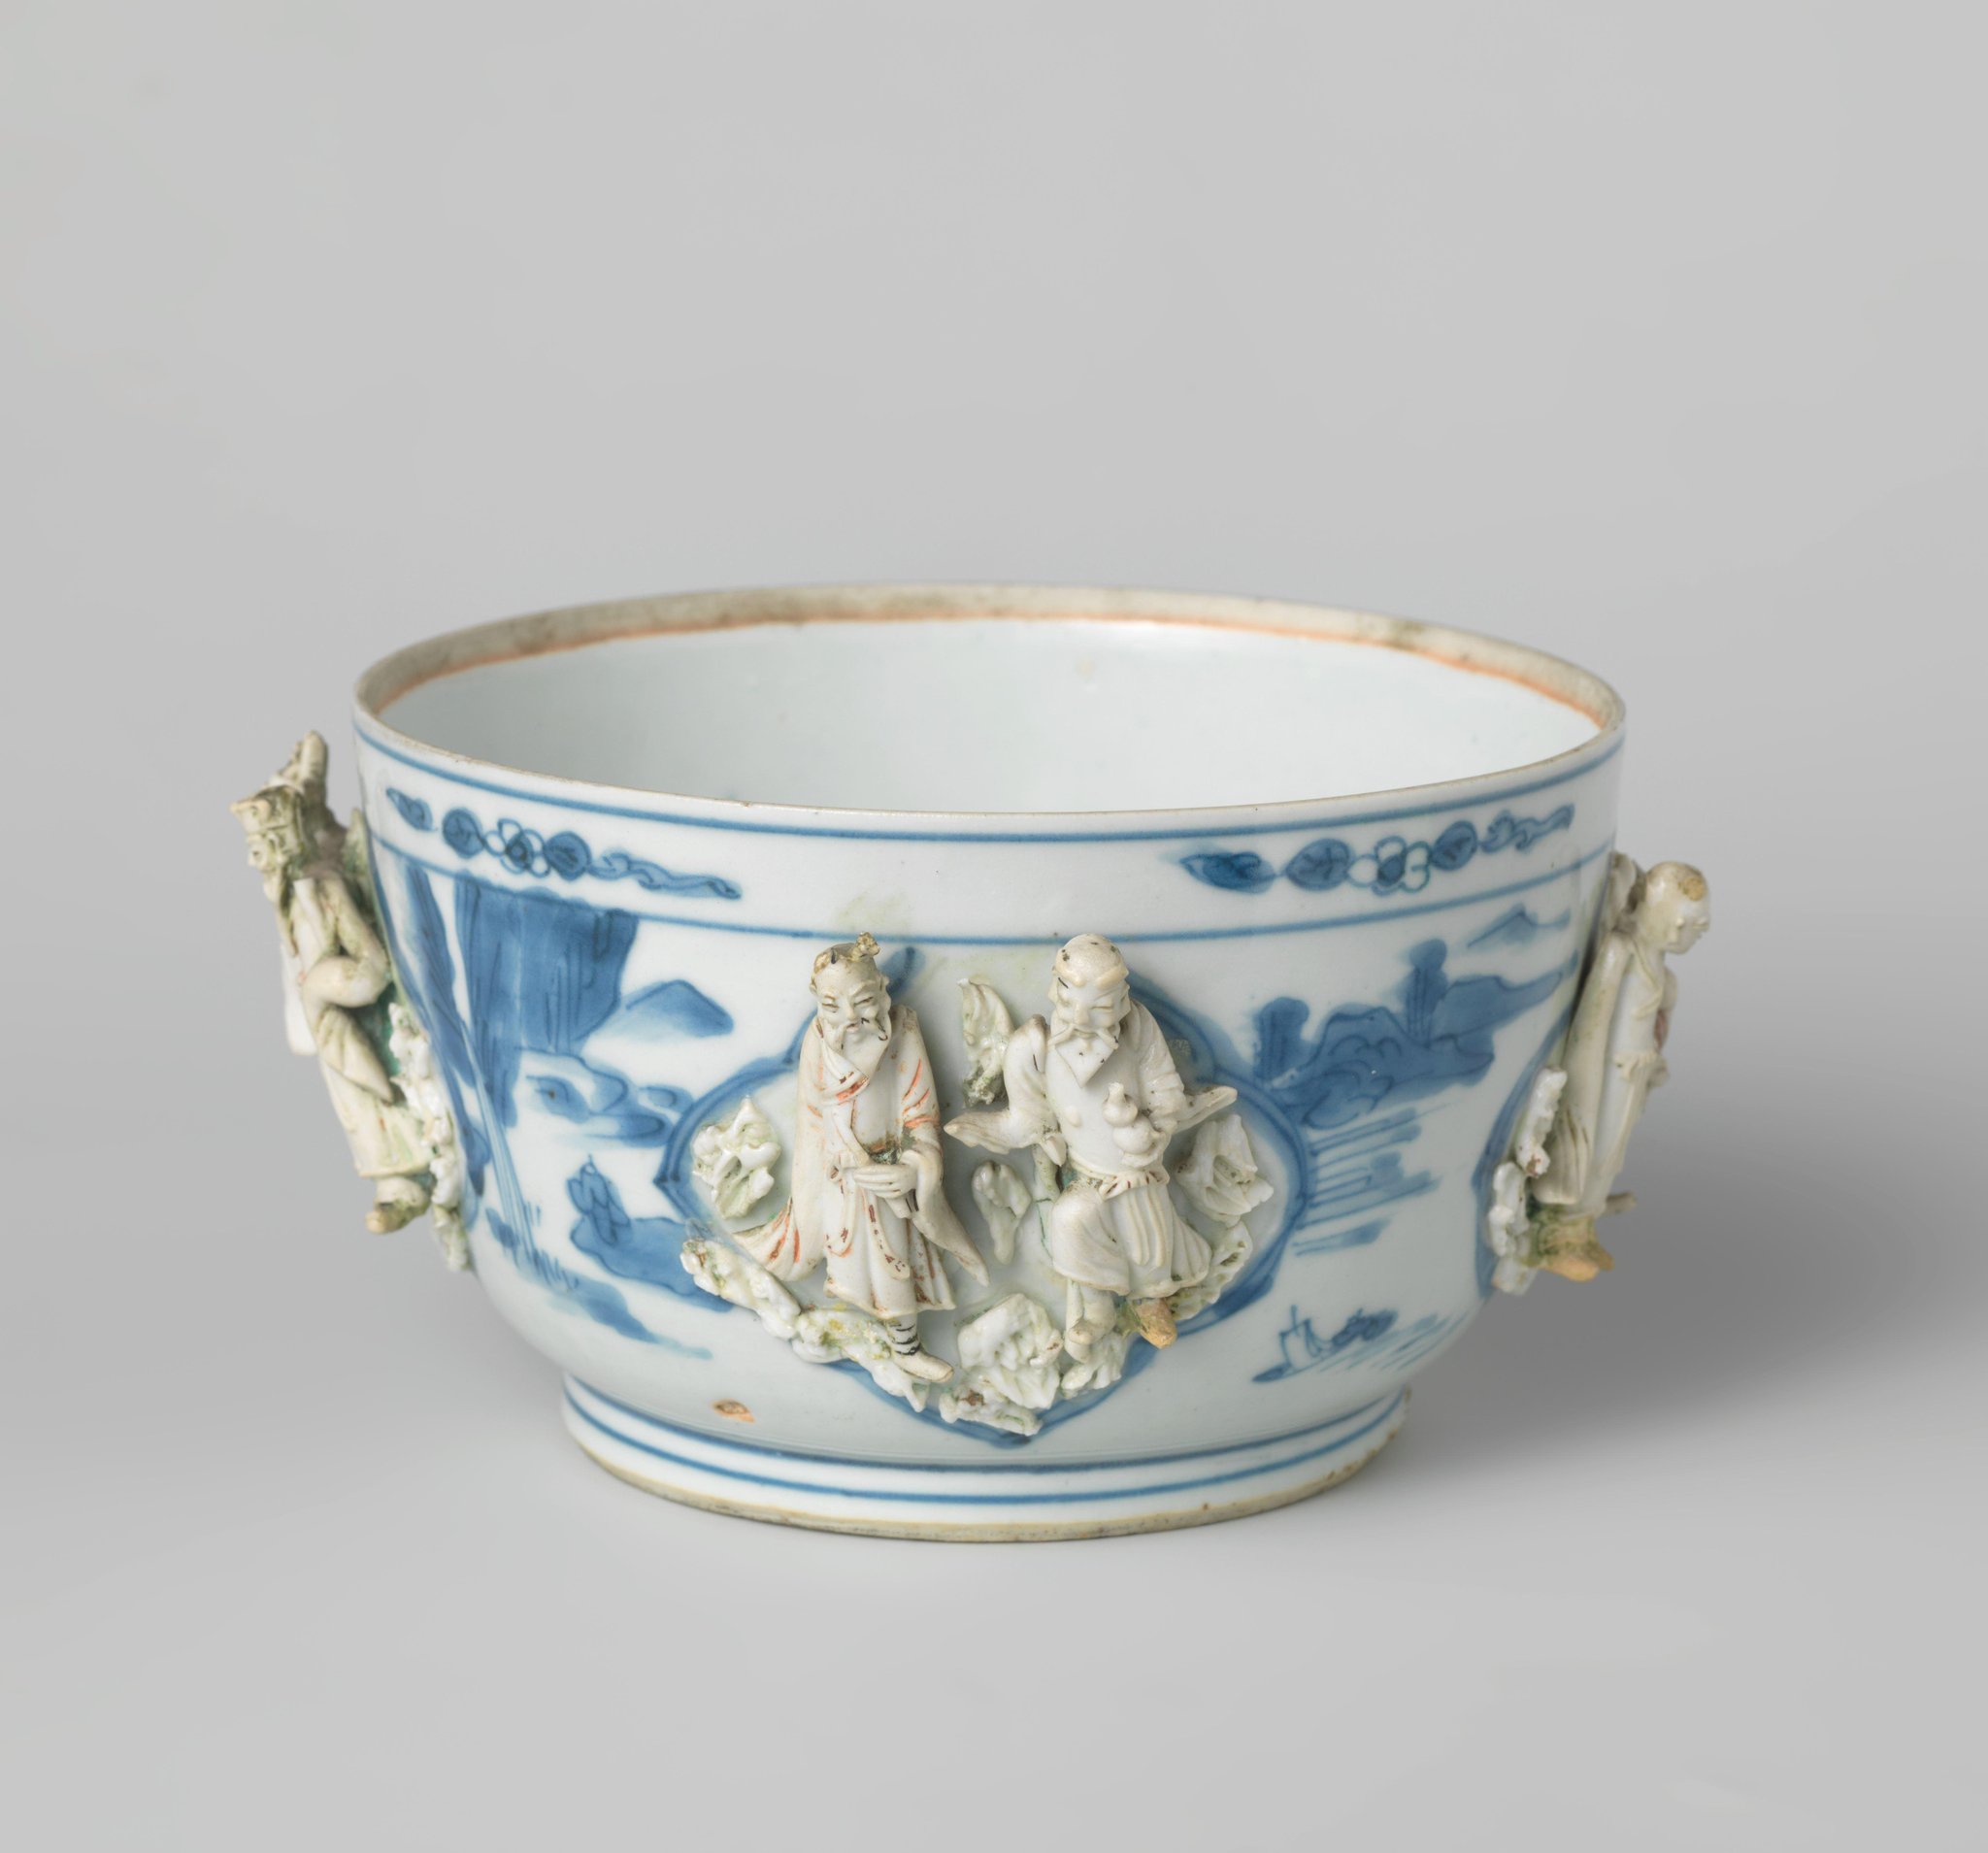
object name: bowl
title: Bowl with landscapes and panels with the Eight Immortals in high relief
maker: Anonymous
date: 1625-1649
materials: cobalt, glaze, paint, porcelain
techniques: firing, turning, vitrification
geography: china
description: Kom, gedecoreerd in onderglazuur blauw en met voorstellingen in hoog relief in biscuit van de 8 onsterfelijken.